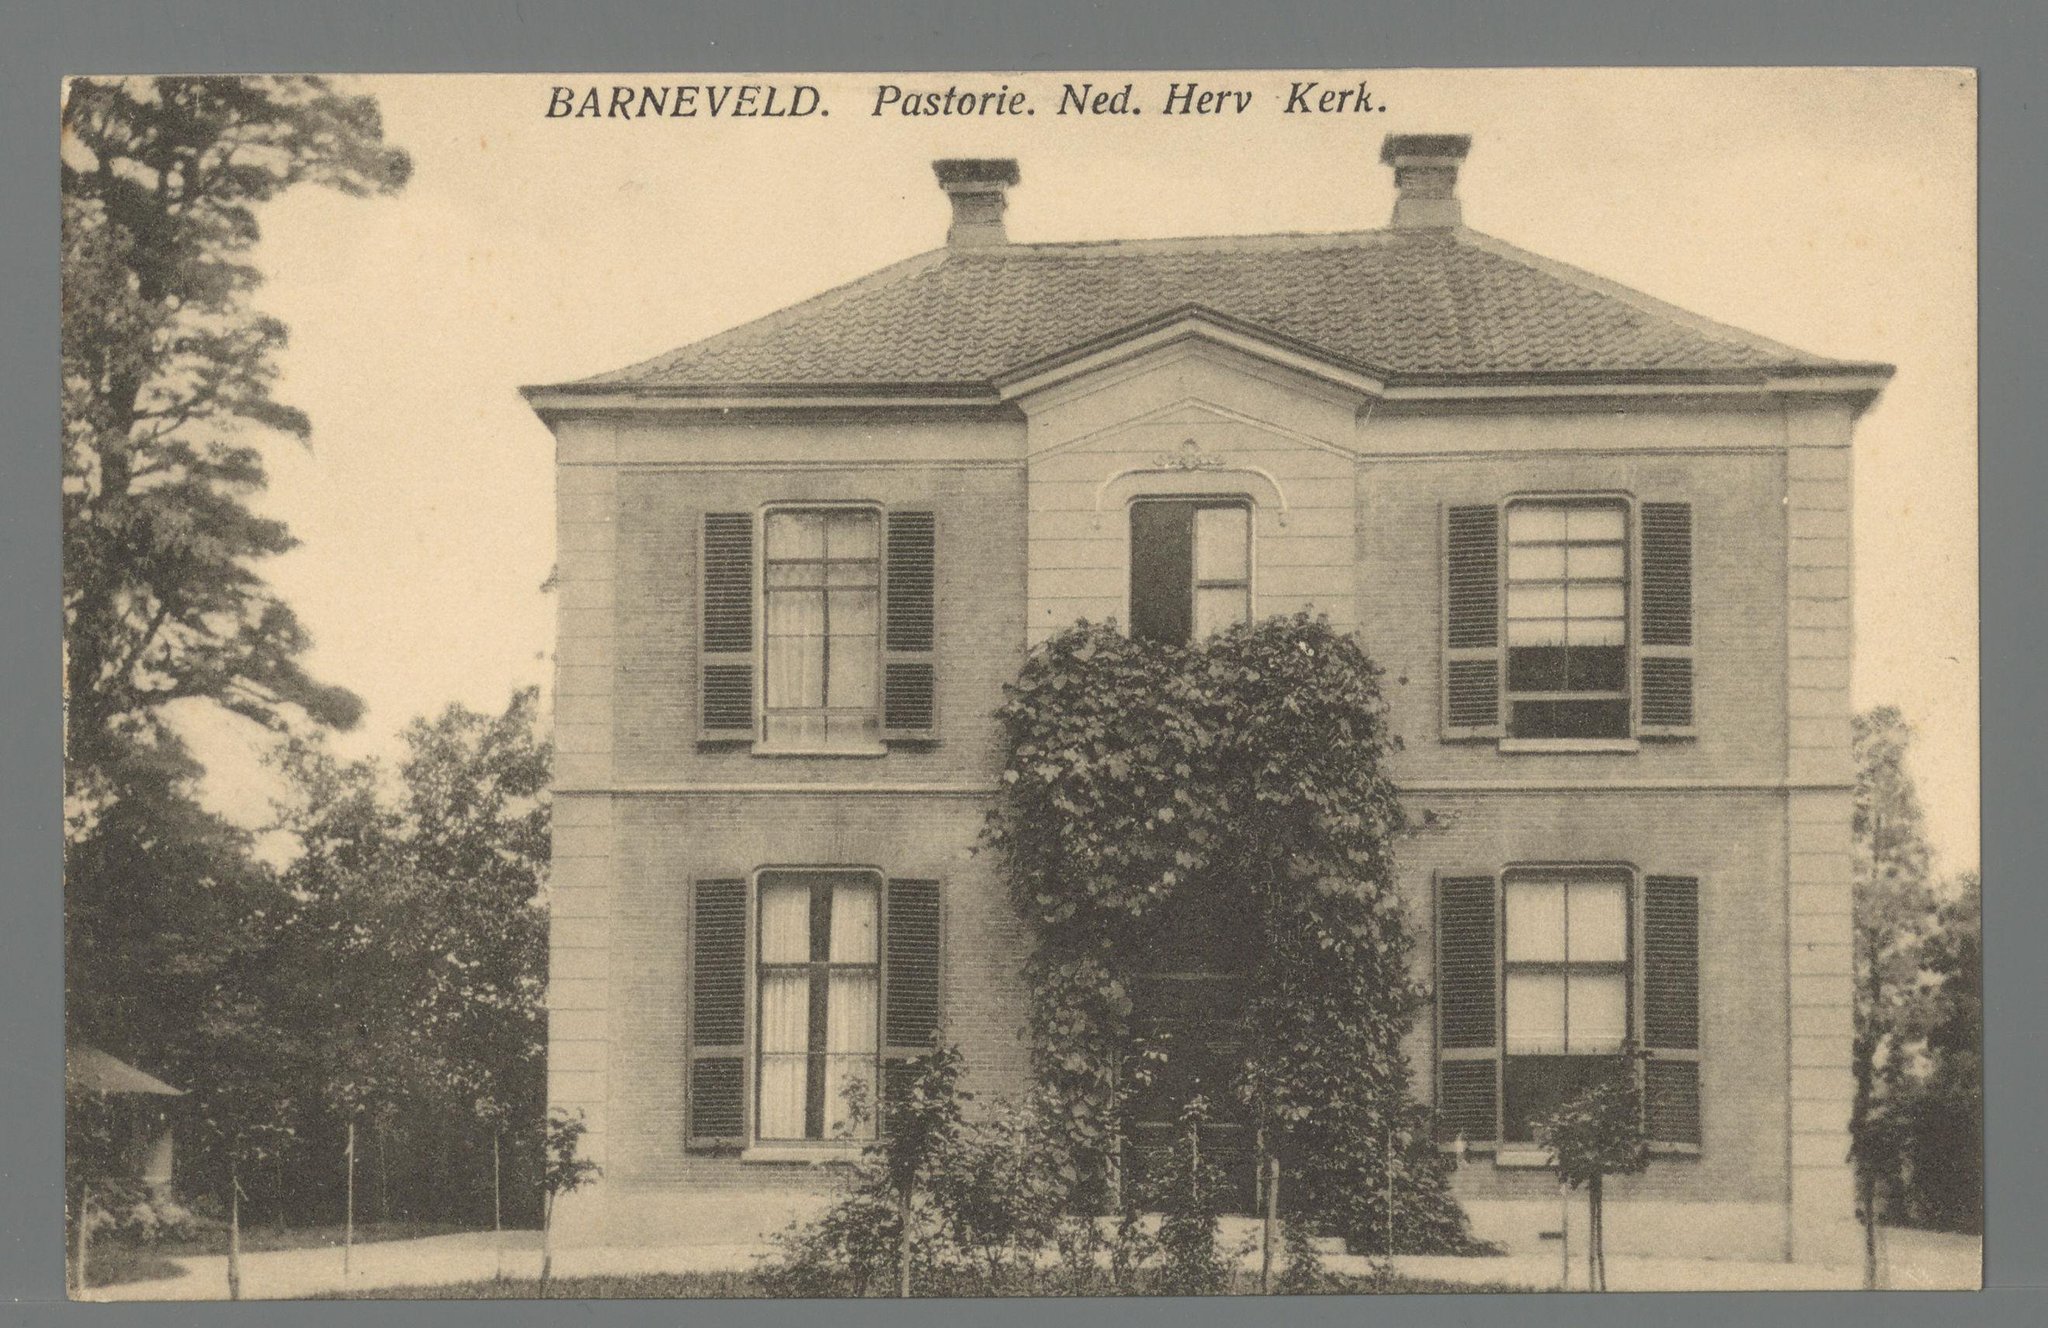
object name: photomechanical print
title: Barneveld. Pastorie. Ned. Herv Kerk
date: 1905-1930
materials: cardboard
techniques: photograph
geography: barneveld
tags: church (exterior)